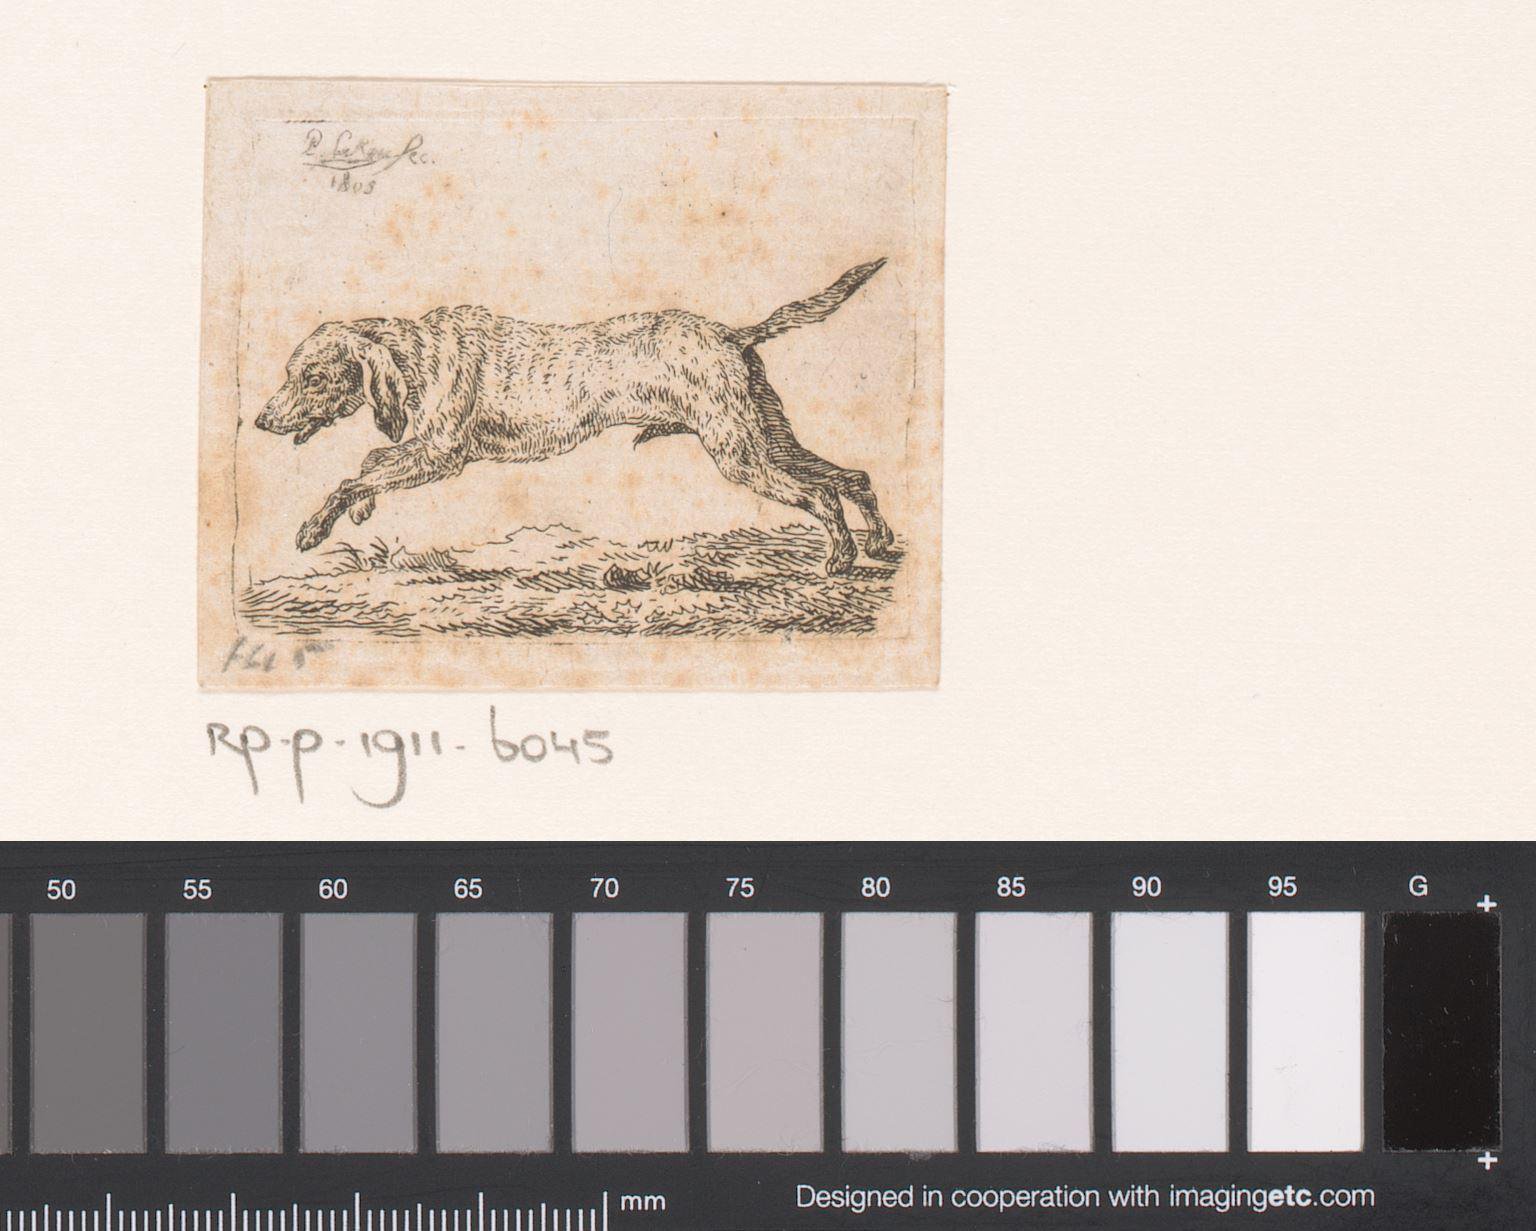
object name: print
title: Rennende hond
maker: pierre-françois le roy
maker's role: draughtsman, painter, print maker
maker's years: 1771-1862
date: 1803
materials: paper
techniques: etching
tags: dog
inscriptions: collector's mark: Lugt 1485, collector's mark: Lugt 2228